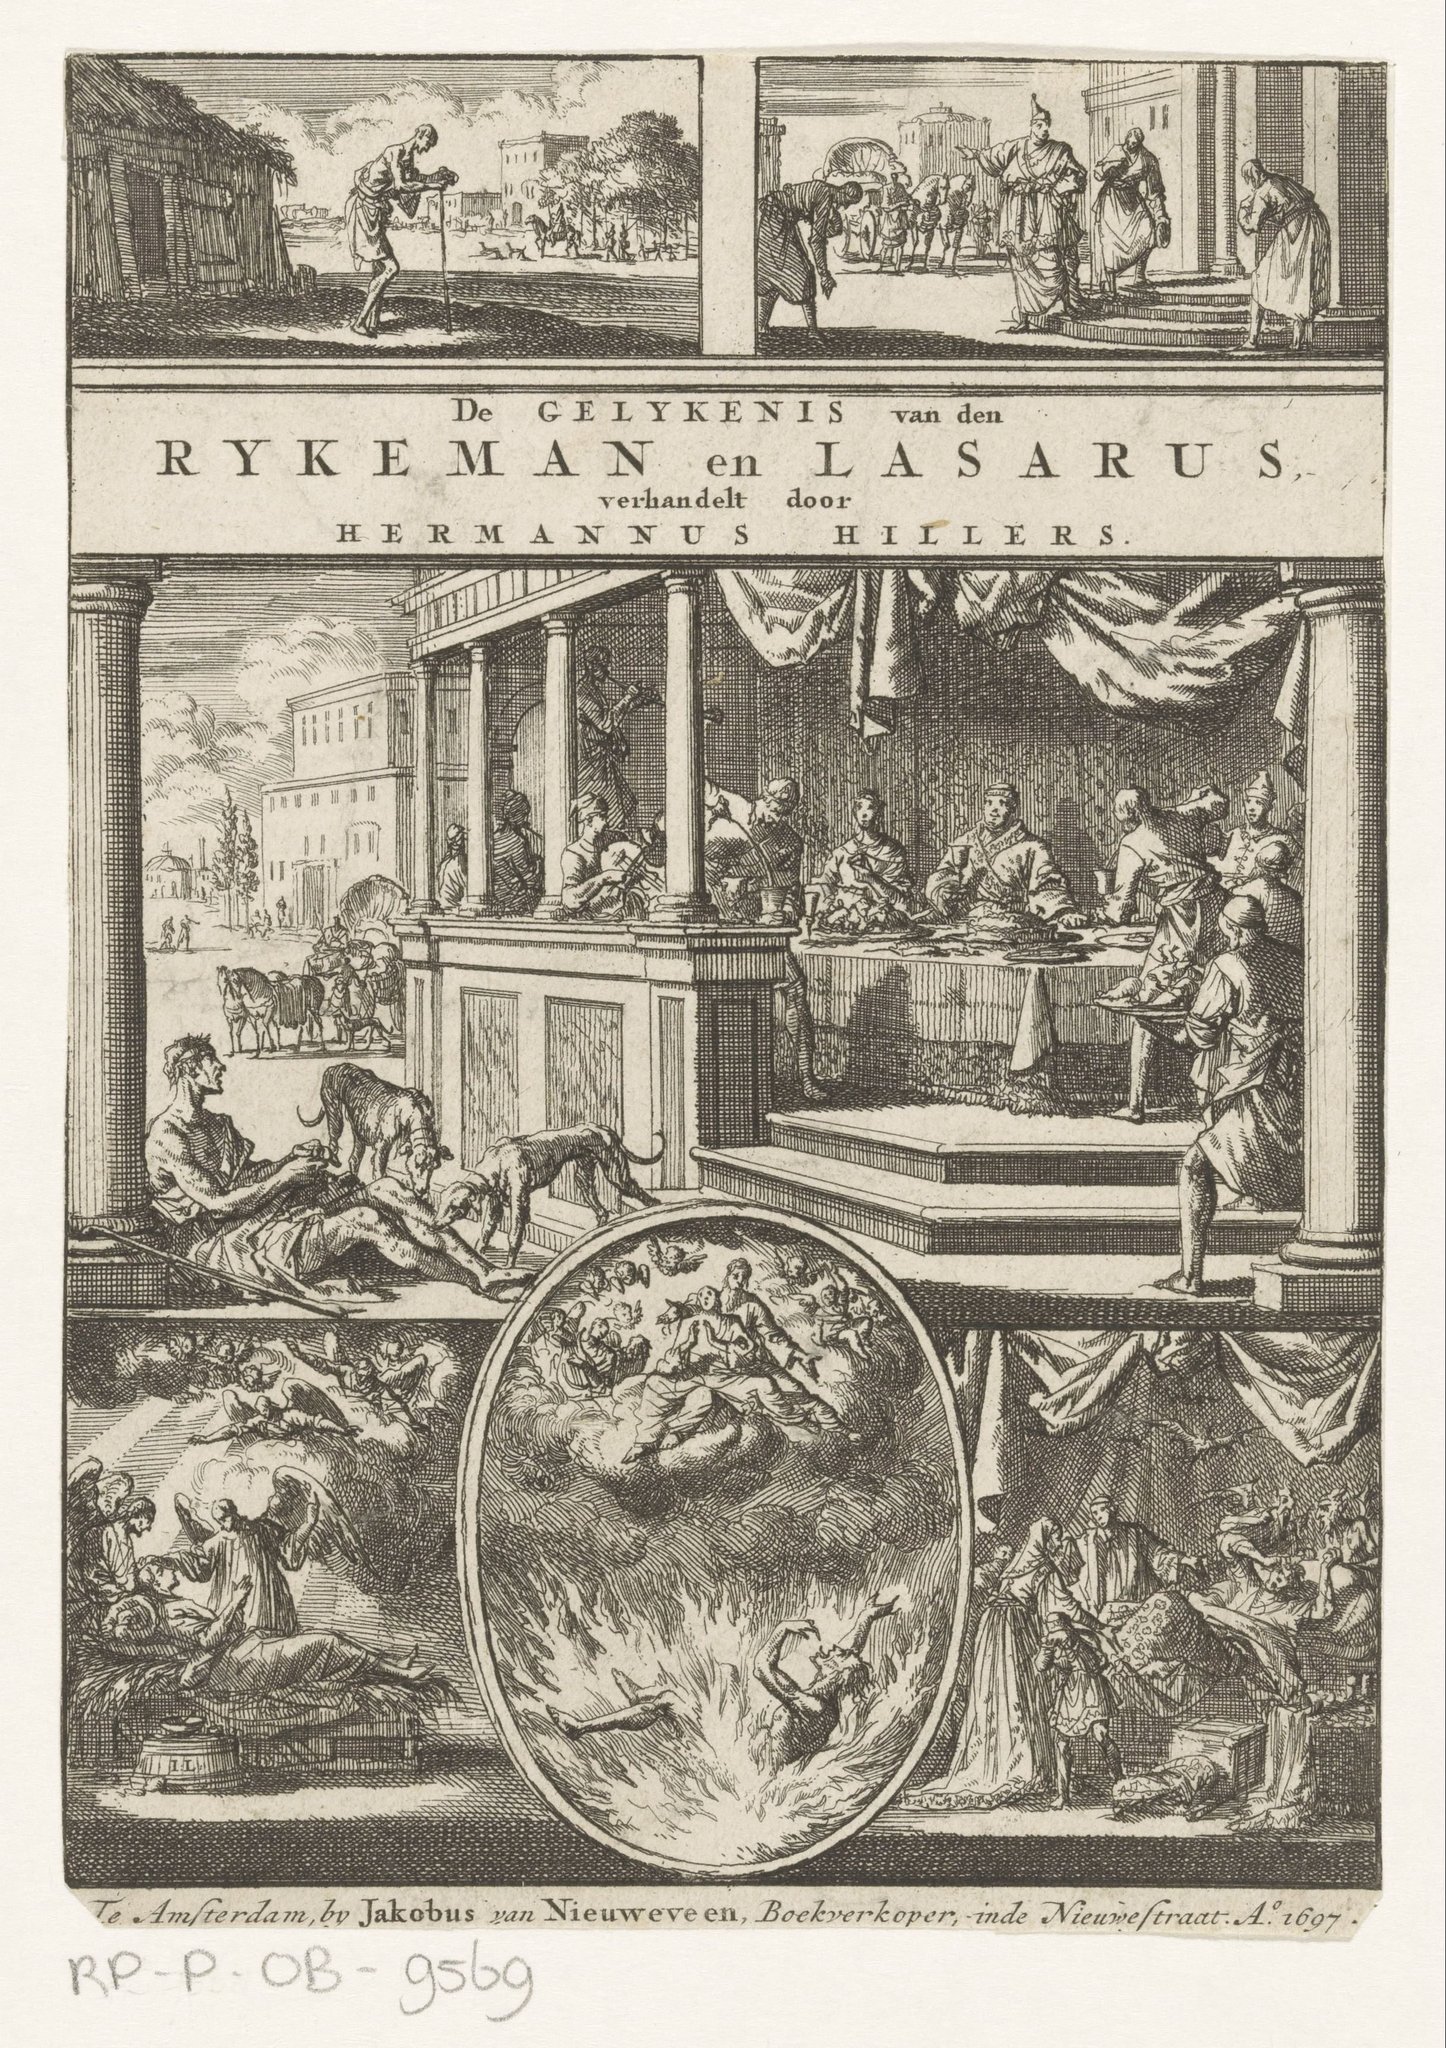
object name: print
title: Titelpagina voor: Herman Hillers, De gelykenis van den ryke man en Lazarus, 1697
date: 1697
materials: paper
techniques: etching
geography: amsterdam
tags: the rich man (dives) is feasting, while poor lazarus is starving at the gate (dogs licking lazarus' sores) (luke 16:19-31)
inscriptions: date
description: De geschiedenis van Lazarus en de rijke man zes voorstellingen. Als centrale voorstelling is de maaltijd van de rijke man weergegeven.